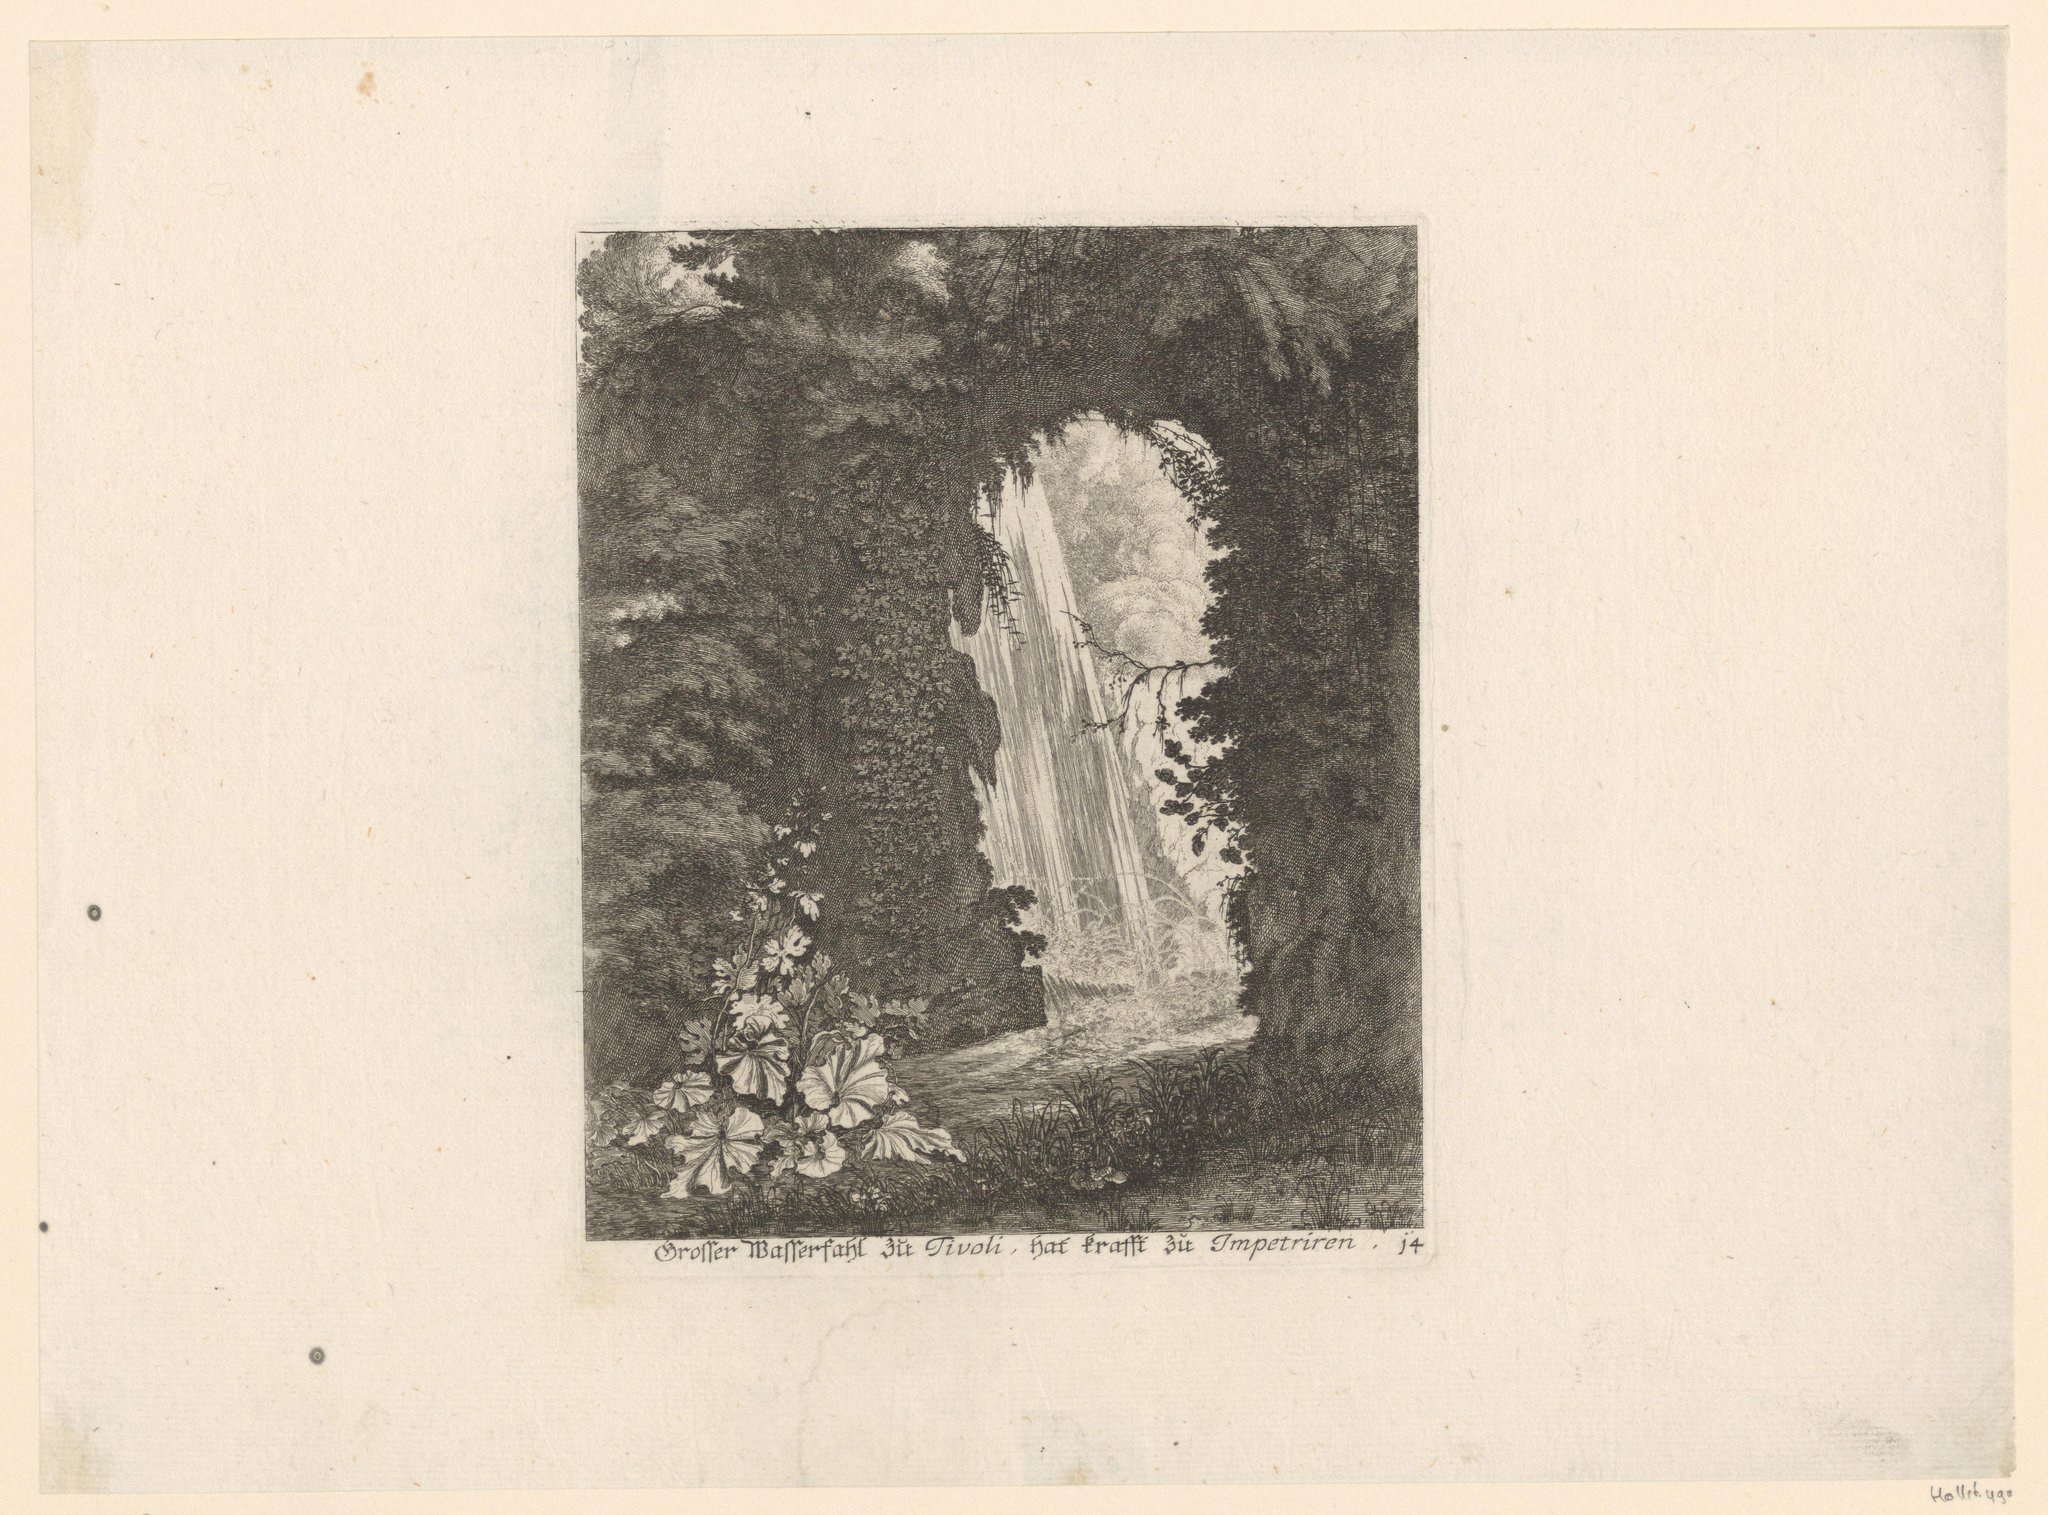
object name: print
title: Mooie en waarachtige landschappen uit Italië en andere landen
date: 1670-1719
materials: paper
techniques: etching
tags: waterfall, rock-formations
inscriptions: number: ‘5’, collector's mark: Lugt 2228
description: Deze prent is deel van de serie: Schöne und Wahre Landschafften in Italien und andern Landern. Augsburg: Johann Ulrich Kraus, 1675-1685. De serie bestaat uit veertien prenten plus een titelprent. Deze uitgave omvat een selectie van de 146 prenten uit de uitgave getiteld 'Joannis Guilielmi Baurn Iconographia completens in se, Passionem (...) Per Italiam, Spectatu Sunt', voor het eerst uitgegeven in Augsburg in 1670.